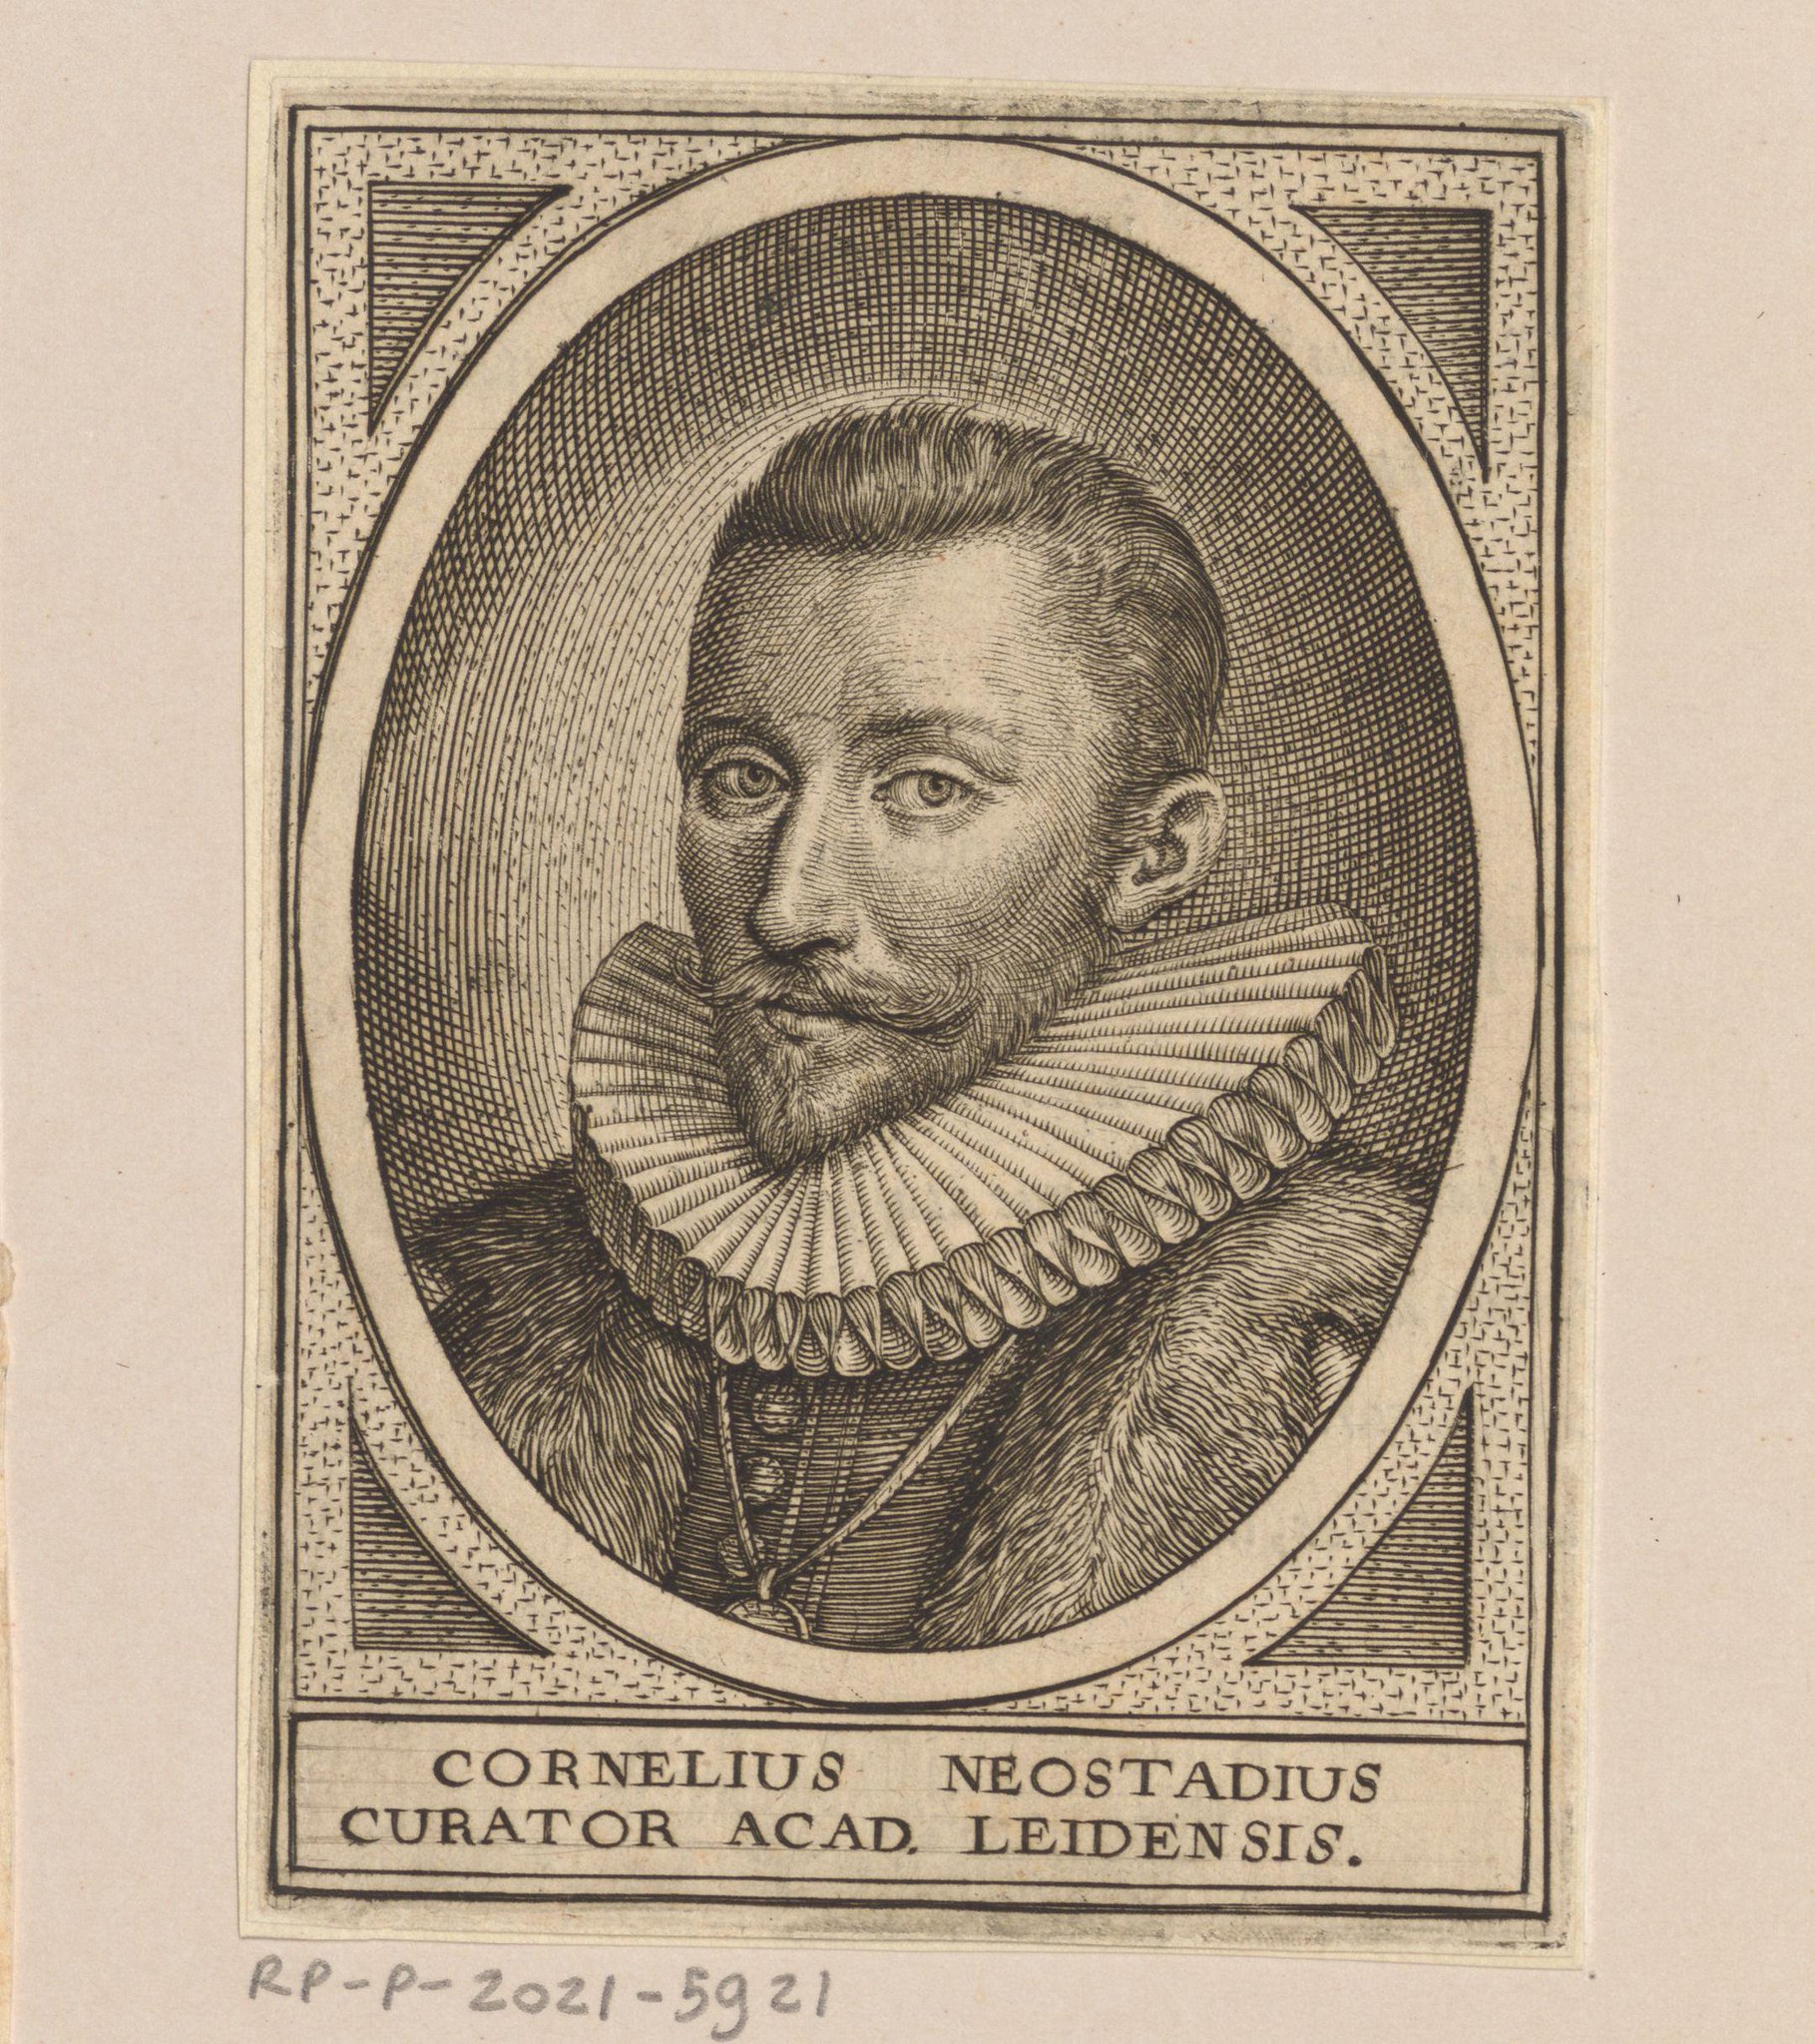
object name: print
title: Portret van Cornelis Matthiasz van Nieuwstadt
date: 1614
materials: paper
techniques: engraving, letterpress printing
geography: leiden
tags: the hague, historical persons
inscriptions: collector's mark: Lugt 2228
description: Prent uit: Illustrium Hollandiae & Westfrisiae ordinum alma academia Leidensis. Leiden: Jacob Marcus en Joost van Colster, 1614.